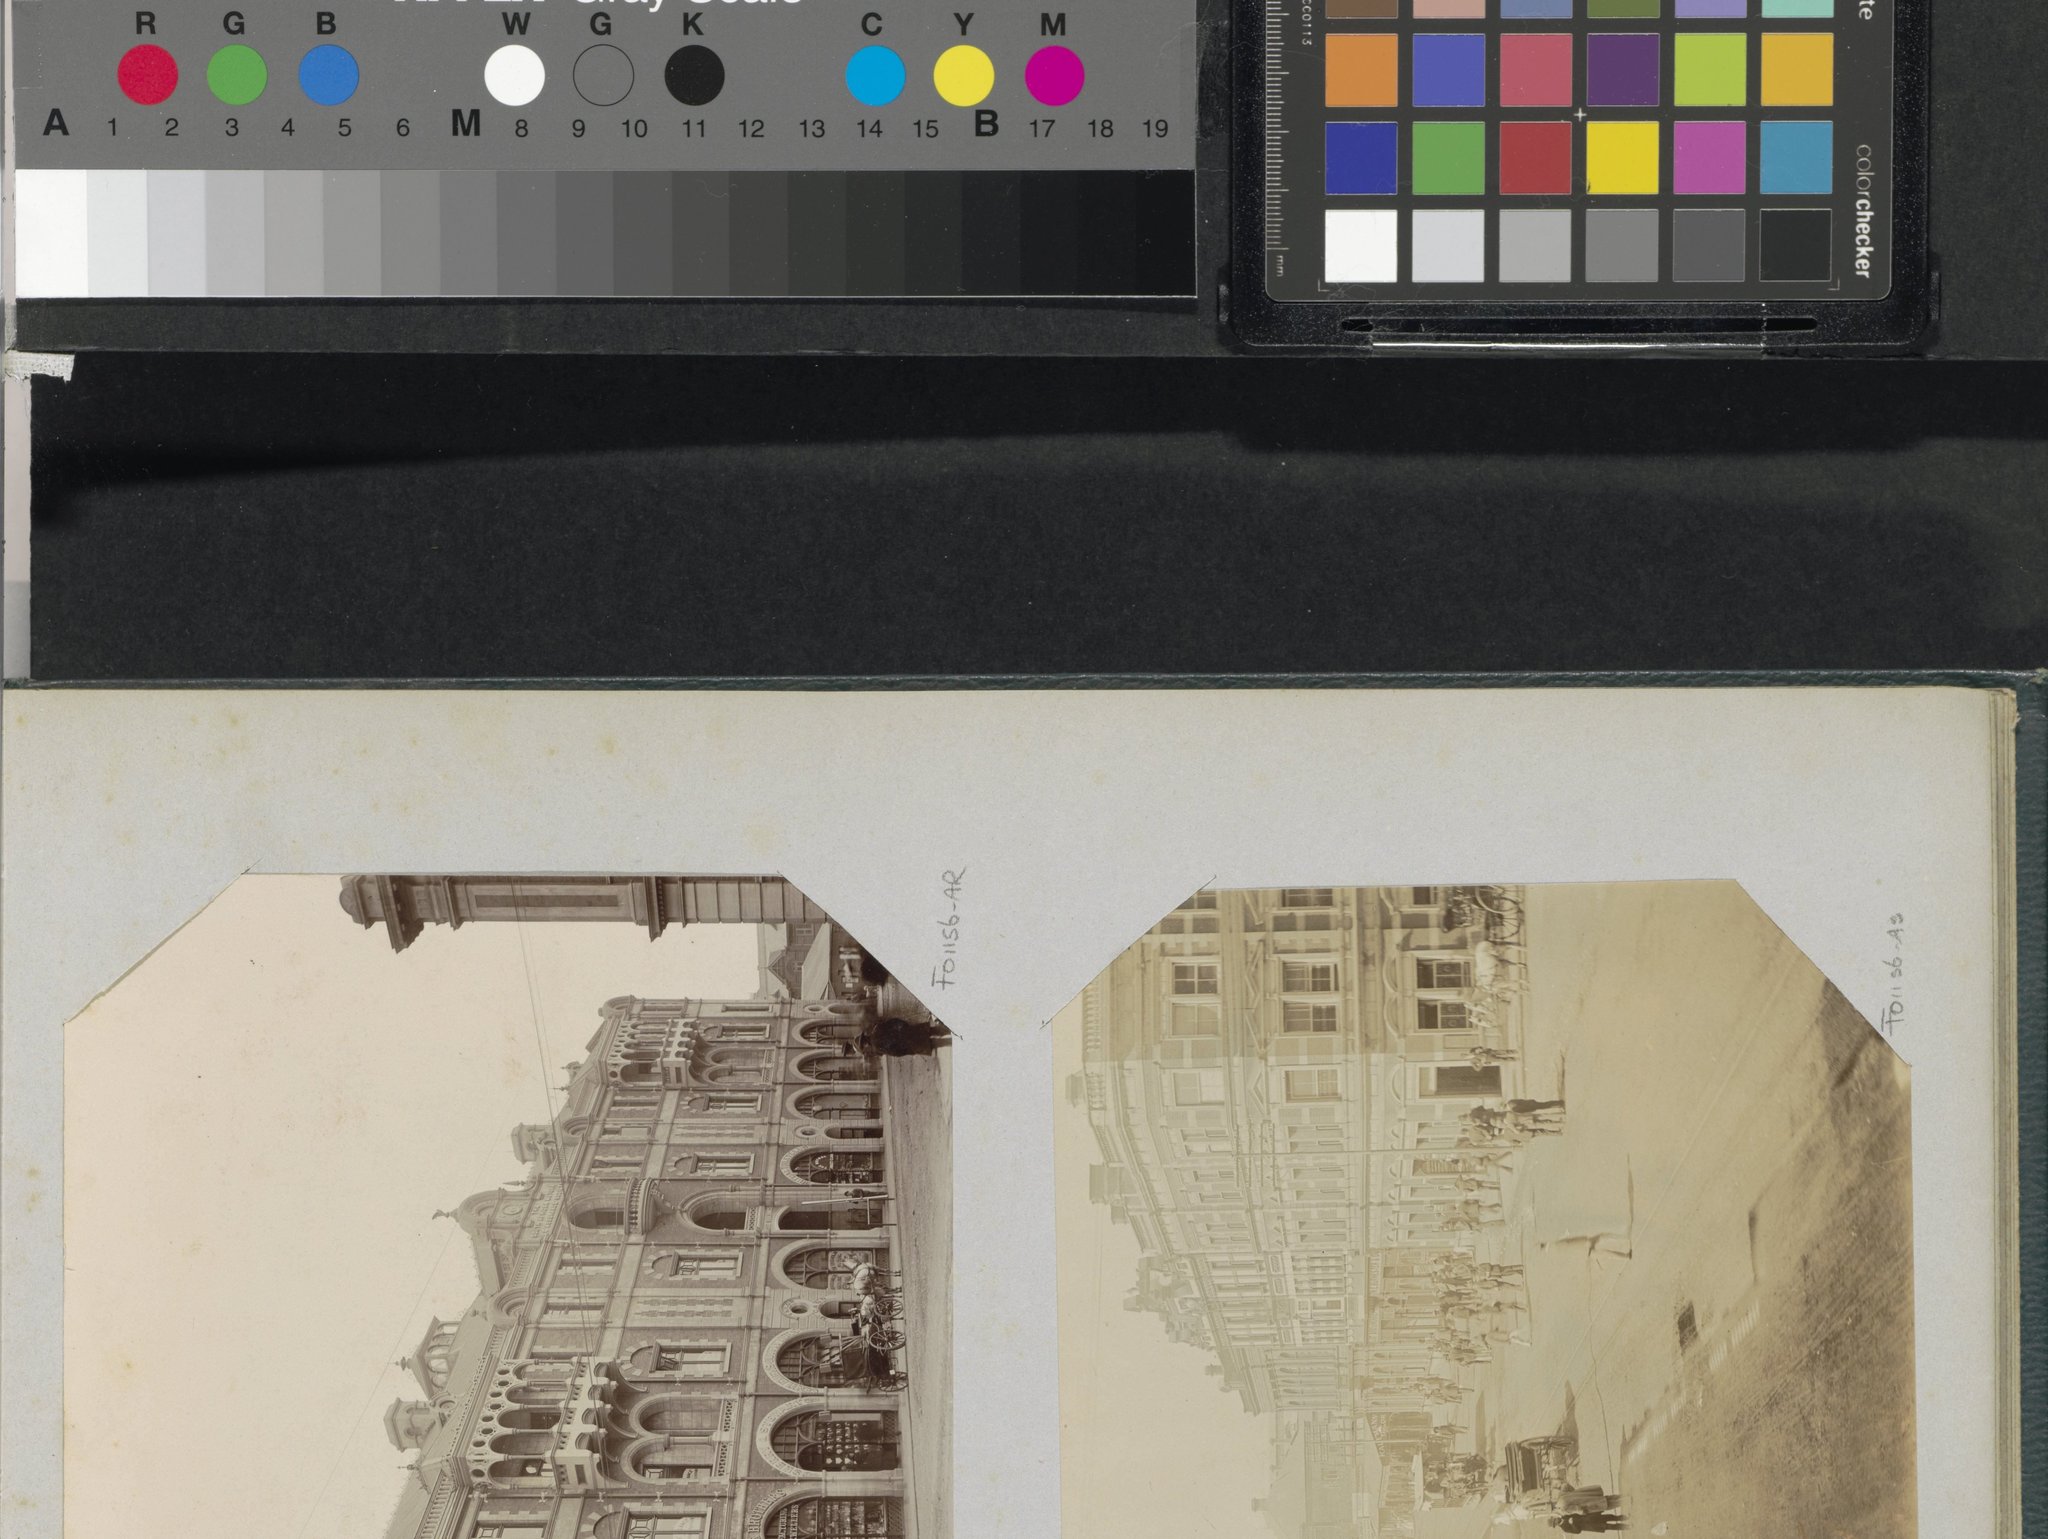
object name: photograph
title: Gezicht op Commissioner Street te Johannesburg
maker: james f. goch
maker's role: fotograaf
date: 1896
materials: photographic support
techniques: gelatin silver print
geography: johannesburg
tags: street (+ city(-scape) with figures, staffage), johannesburg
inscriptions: inscription: ‘Commissioner St/ Johannesburg/ Goch No 9’